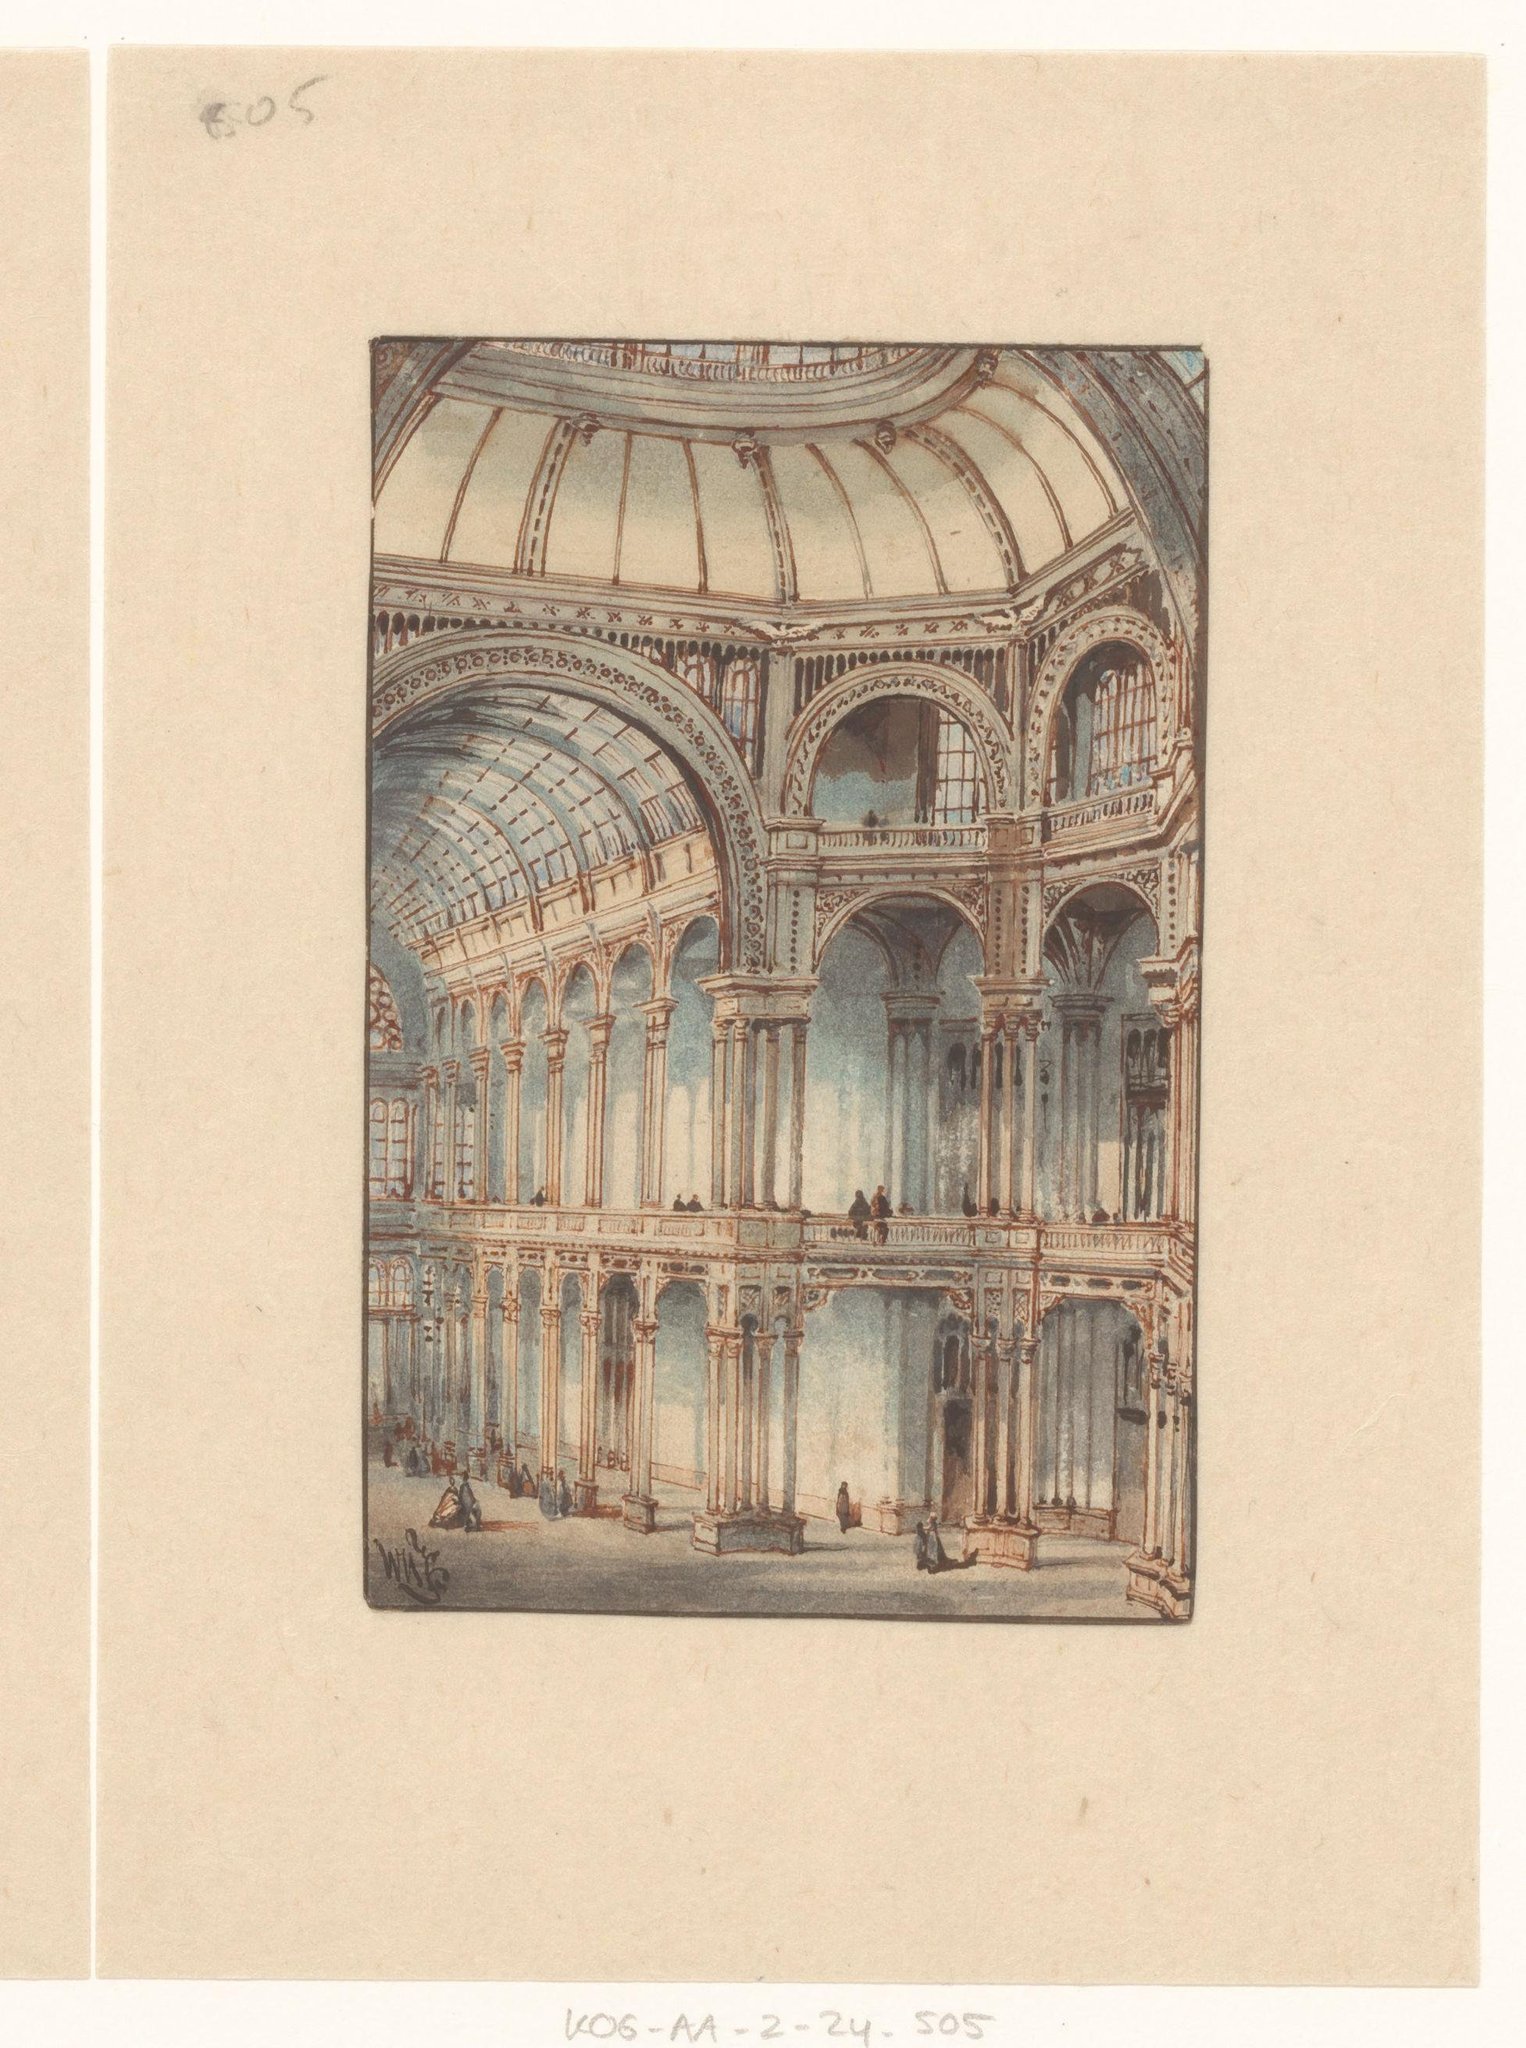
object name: drawing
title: Interieur van het Paleis voor Volksvlijt, gezien naar de Grote Zaal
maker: willem hekking jr.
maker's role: print maker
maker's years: 1825-1904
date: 1864-1904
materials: ink, paper, watercolor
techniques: brush, pen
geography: amsterdam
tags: permanent exhibition, museum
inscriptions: collector's mark: Lugt 800a, signature: ‘WHjr’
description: Tekening binnen de Atlas Van Eck ingedeeld op wijknummer 24.